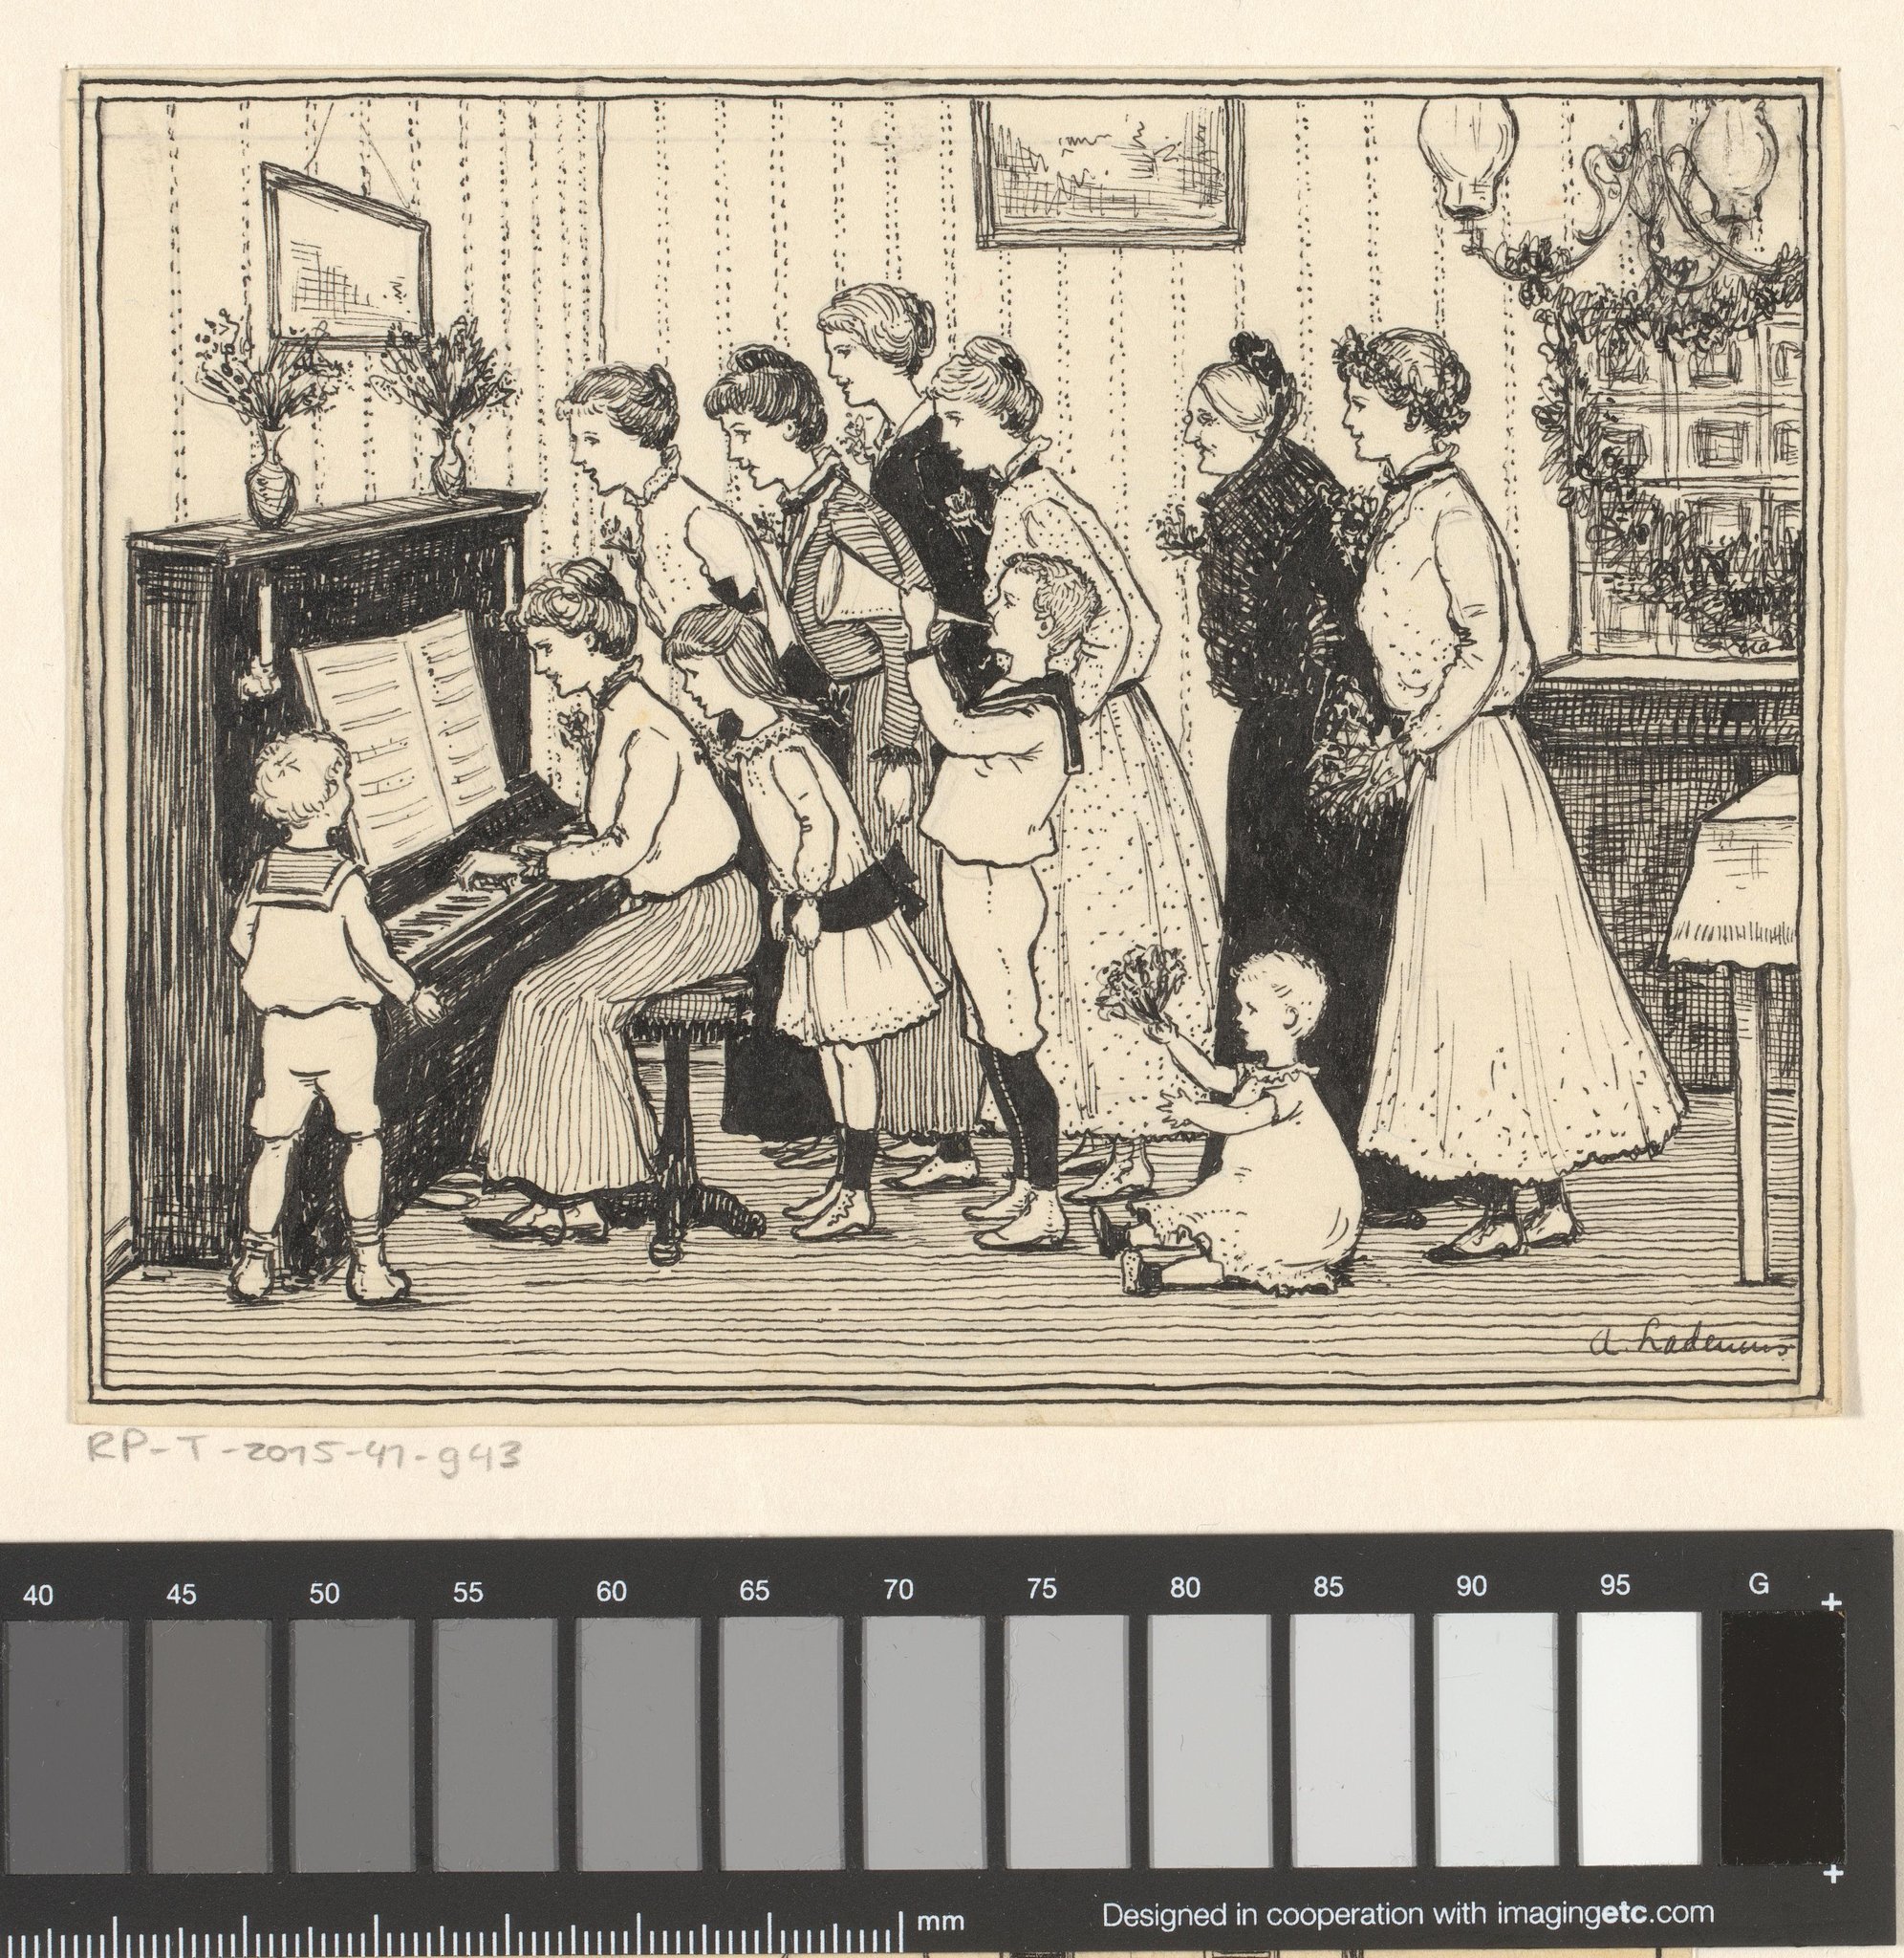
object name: drawing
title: Familie rond een piano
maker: adri ladenius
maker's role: draughtsman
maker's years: 1883-1953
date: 1893-1953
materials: ink, paper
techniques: pen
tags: flowers, pianoforte (+ artist at work), family relationships (first, second, third and fourth degree), generations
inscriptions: signature: ‘A. Ladenius’, collector's mark: Lugt 2228, :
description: In een kamer speelt een vrouw op een piano. Vrouwelijke familieleden en kinderen hebben zich rond de piano geschaard. Ze dragen bloemen in de hand, in het haar en in de vorm van corsages op de kleding. Ook het venster is met bloemenslingers versierd.